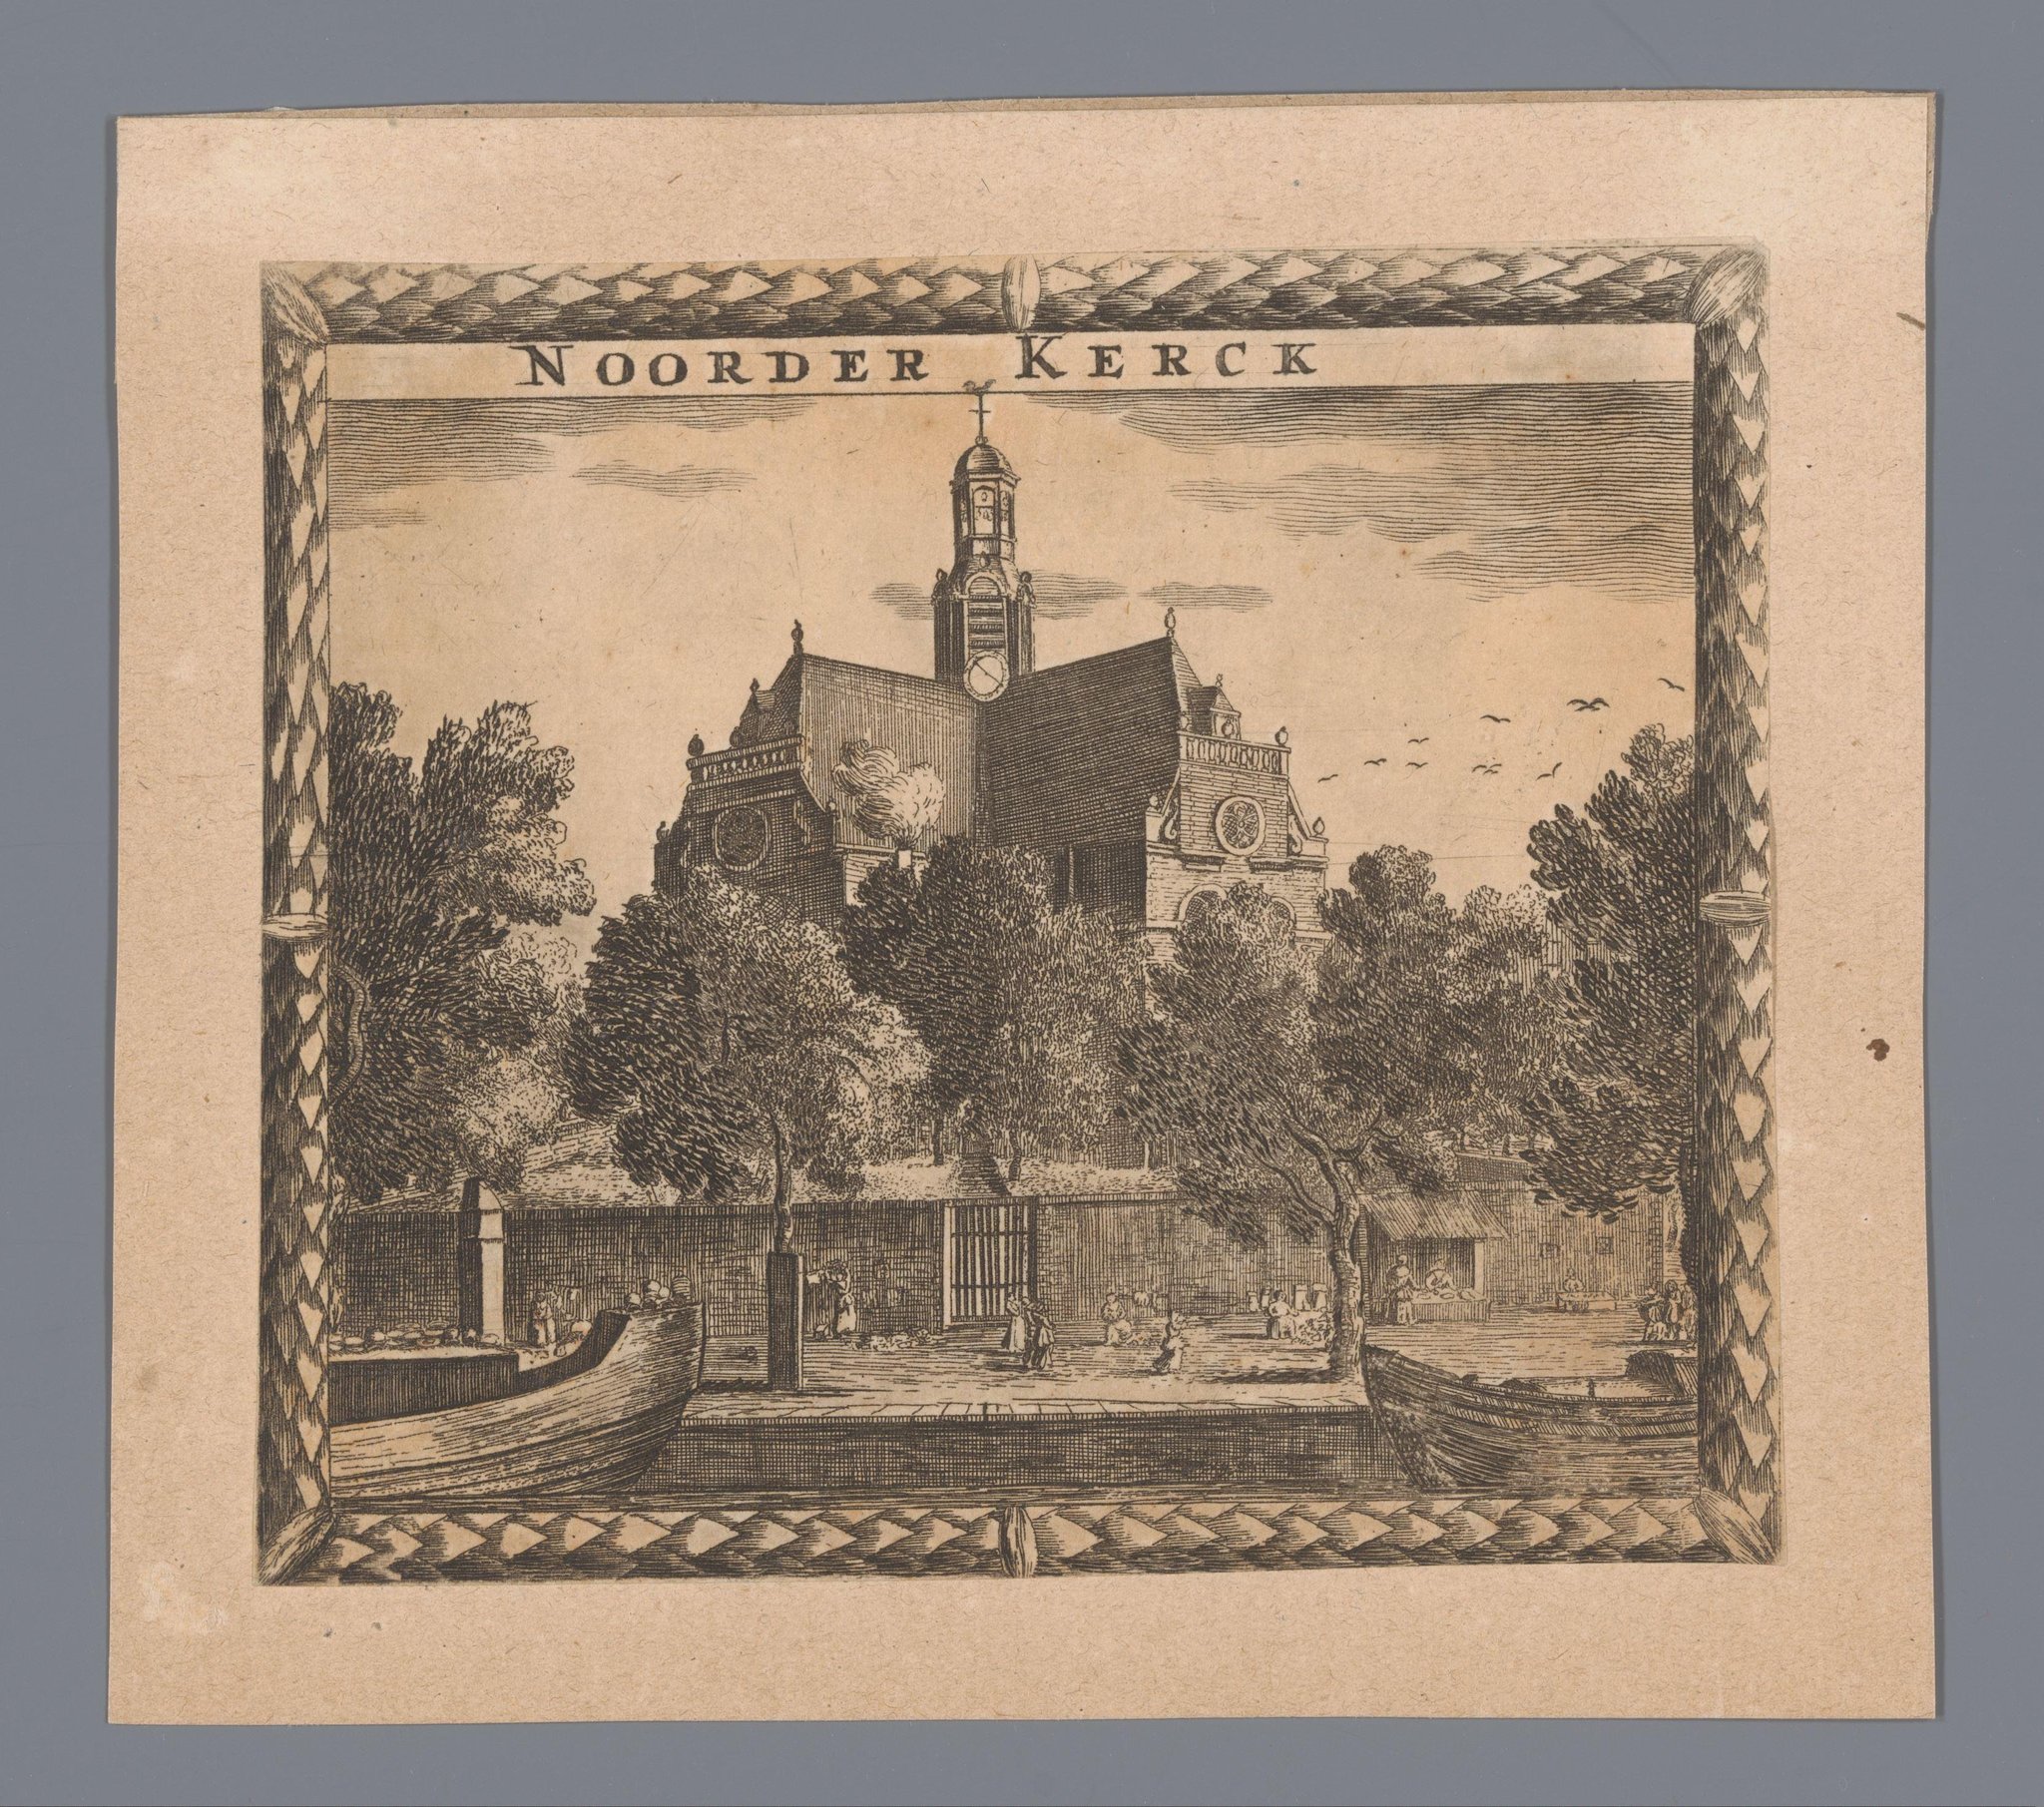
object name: print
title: Gezicht op de Noorderkerk te Amsterdam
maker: Anonymous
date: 1680-1730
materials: paper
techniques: etching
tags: church (exterior)